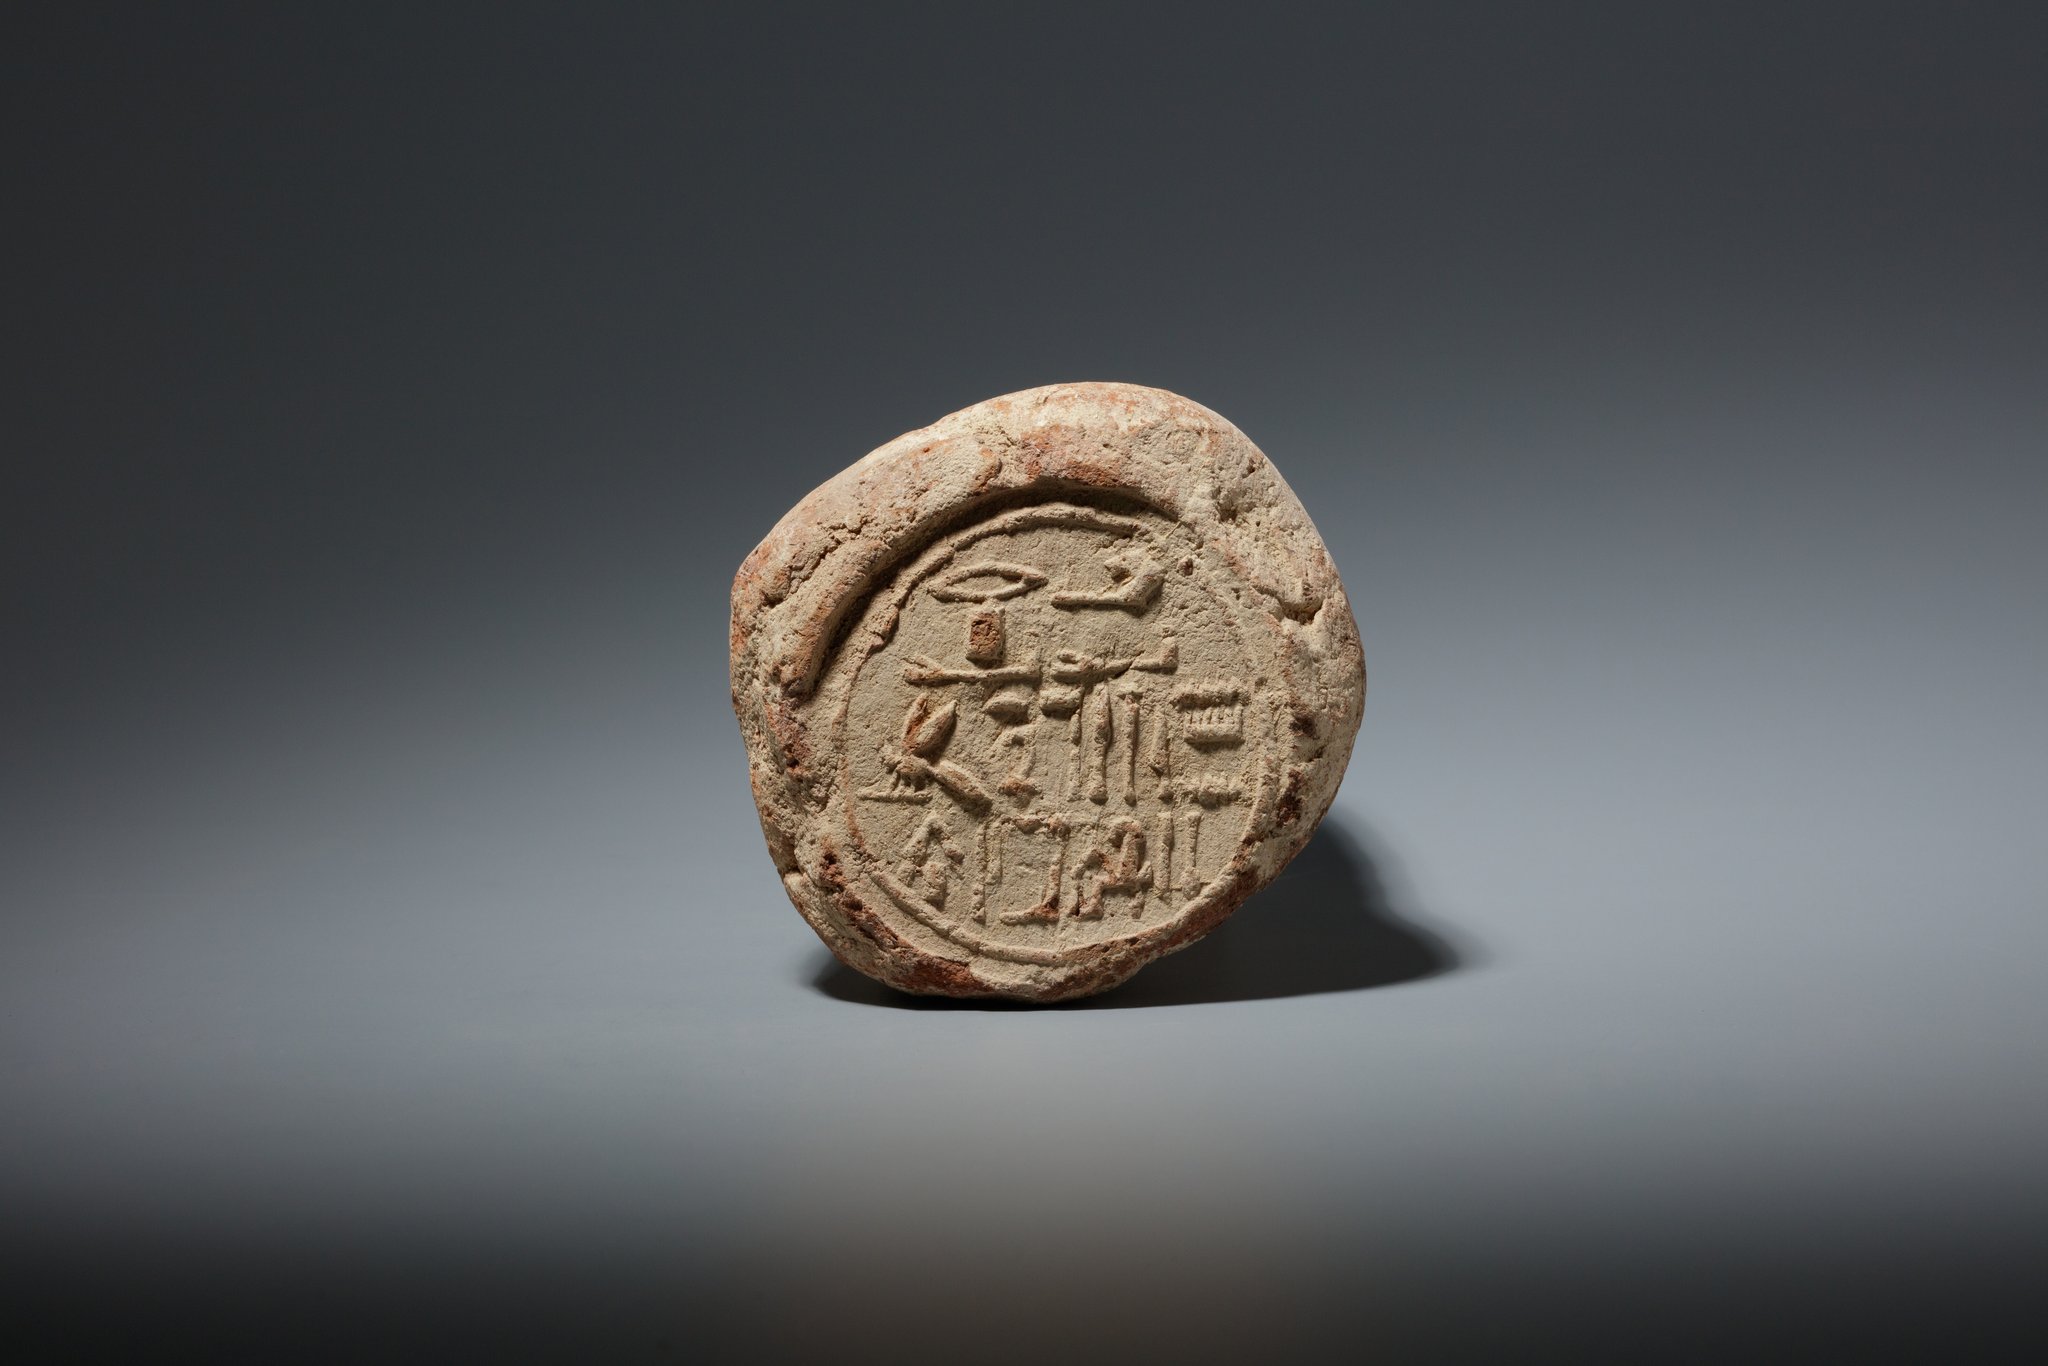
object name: cone, davy 518, hapuseneb, prophet, amun, seal bearer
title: Funerary Cone of the High Priest of Amun Hapuseneb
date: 1479-1458 BCE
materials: pottery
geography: egypt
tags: hieroglyphs